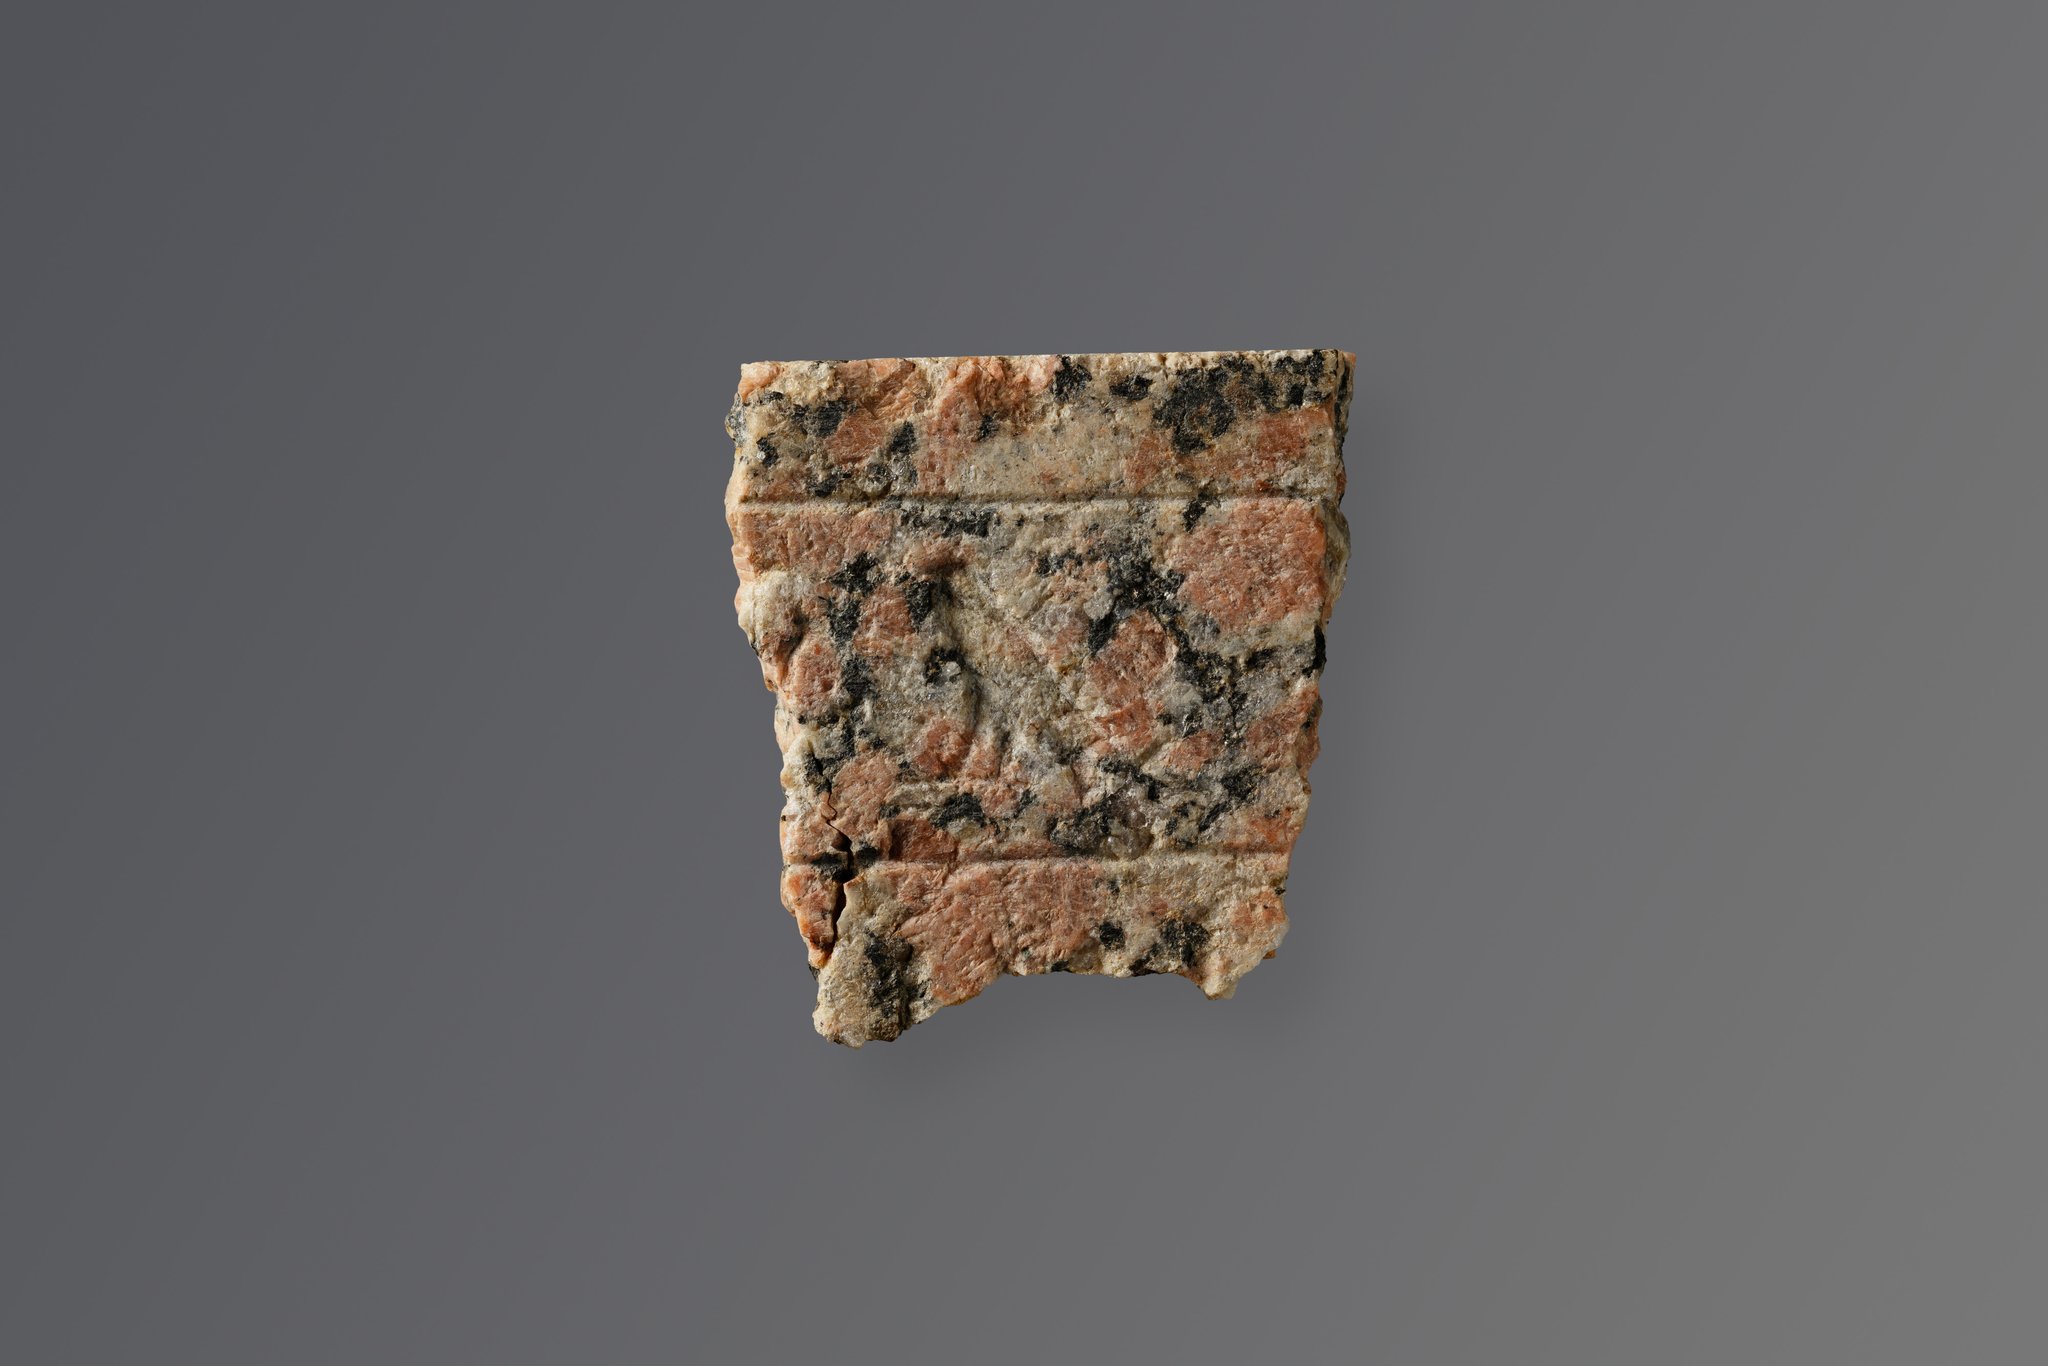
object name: relief fragment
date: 1981-1640 BCE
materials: granite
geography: egypt